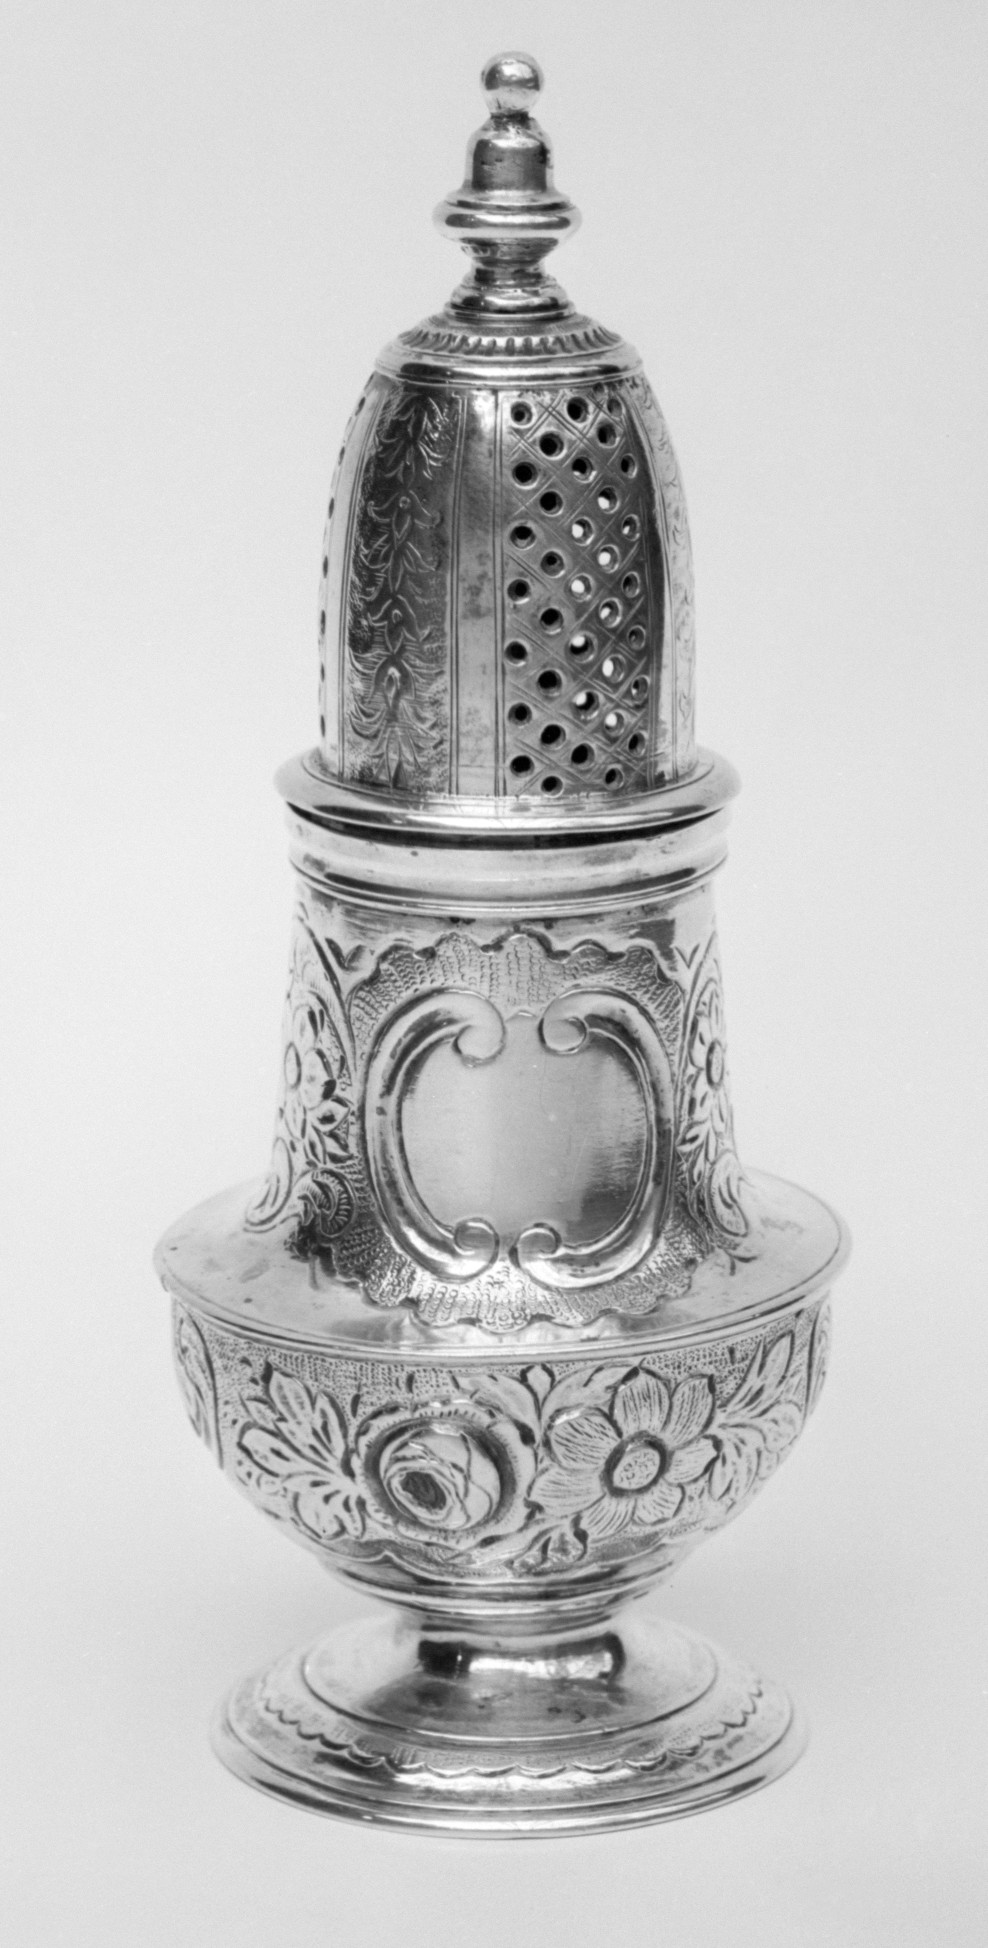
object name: caster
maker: i. b.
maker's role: maker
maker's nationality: british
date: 1734-1766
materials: silver